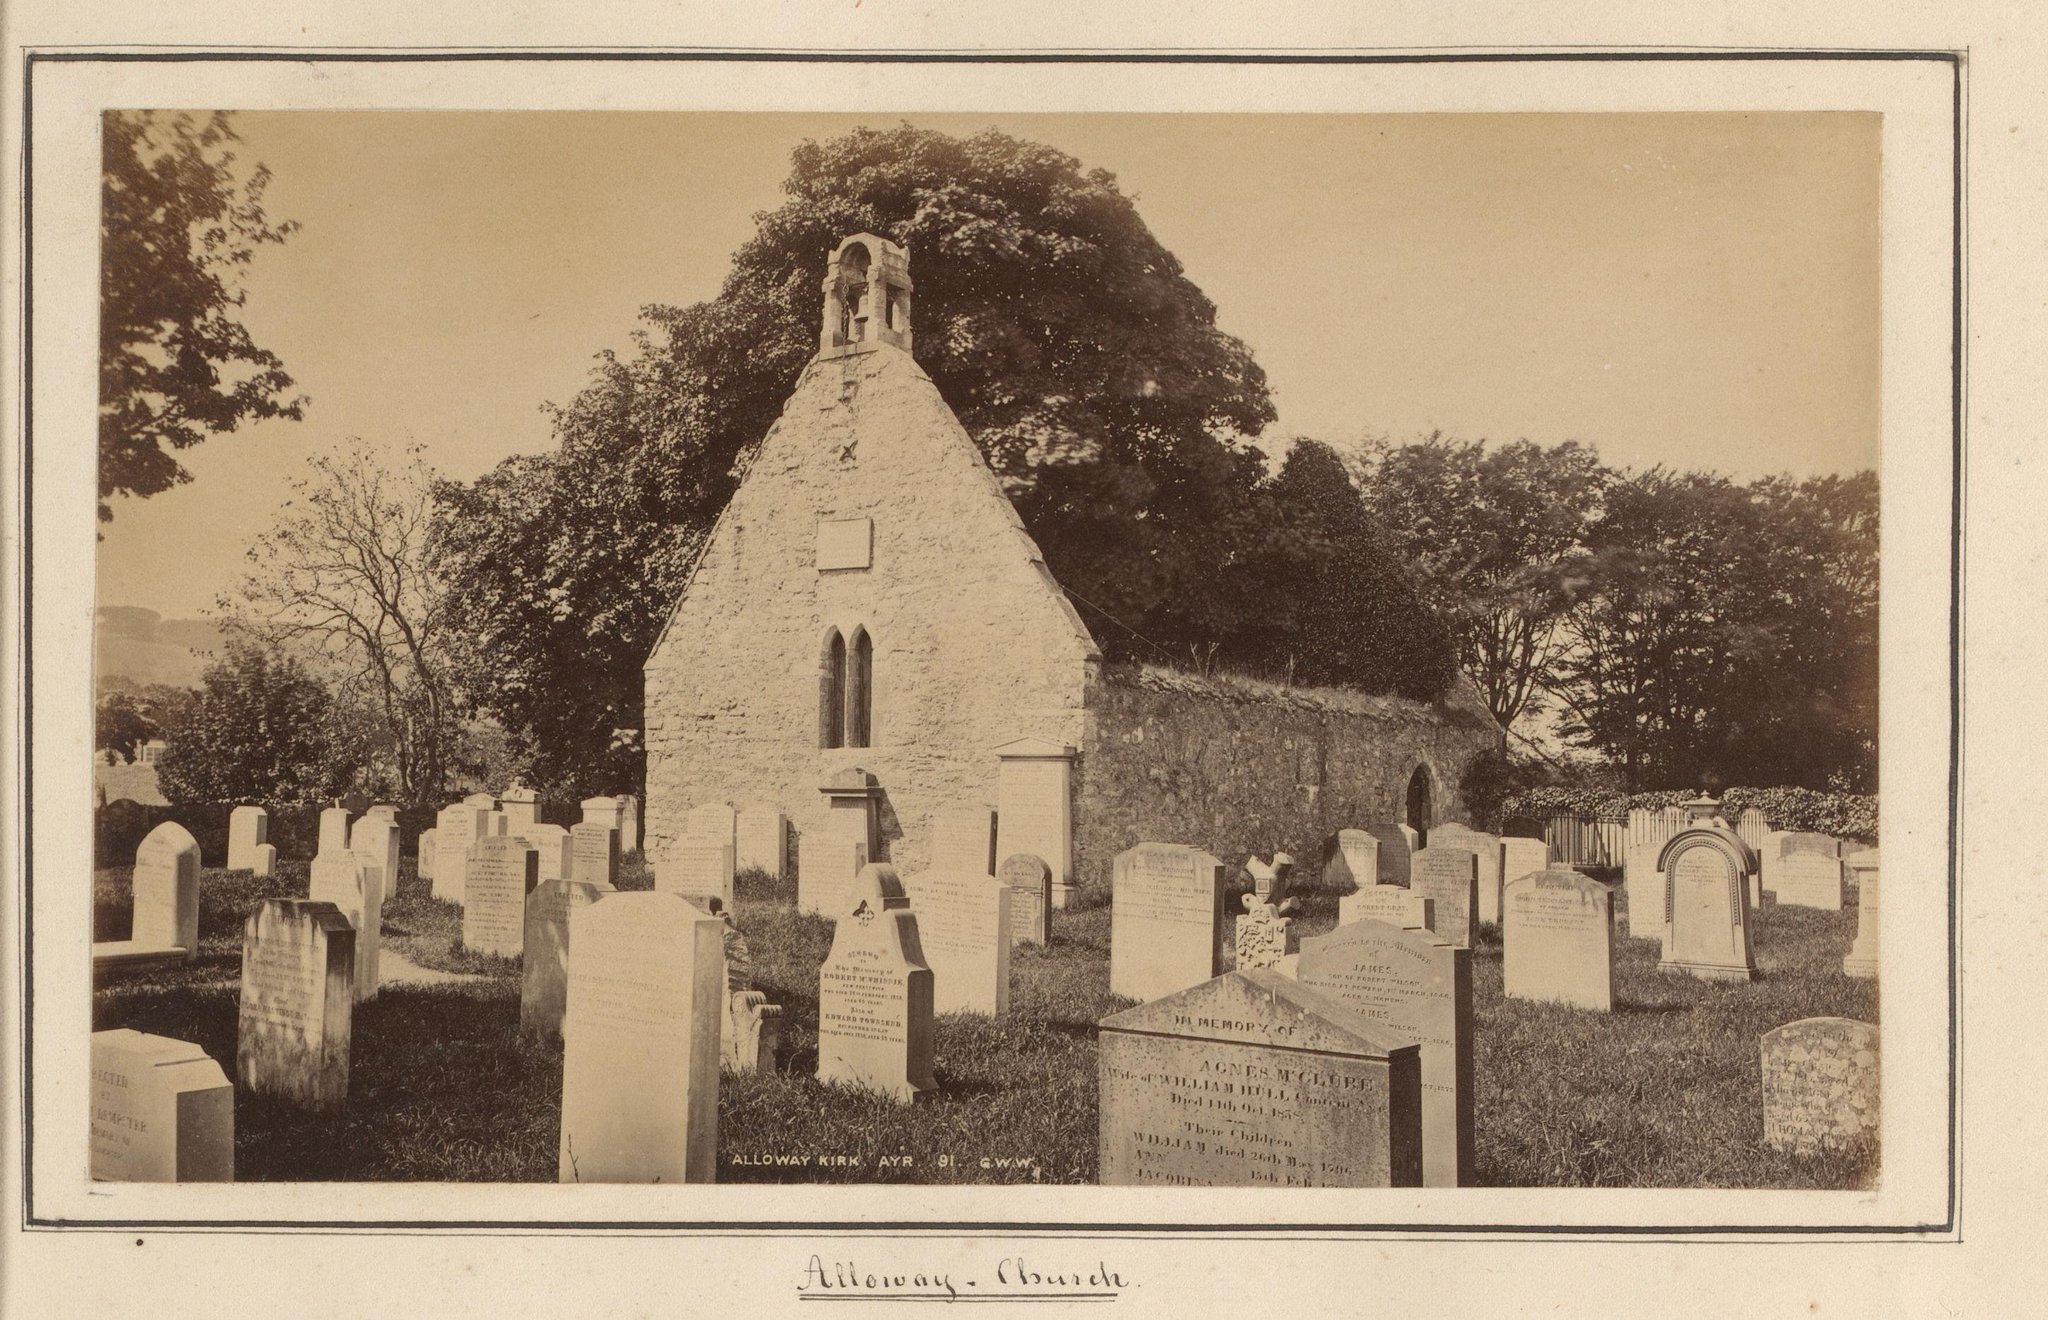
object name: photograph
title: Auld Kirk te Alloway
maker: george washington wilson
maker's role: publisher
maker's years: 1823-1893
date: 1870-1890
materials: paper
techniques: albumen print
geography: alloway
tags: ruin of church, monastery, etc., churchyard, cemetery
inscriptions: inscription: ‘Alloway Kirk. Ayr. 91. G.W.W.’